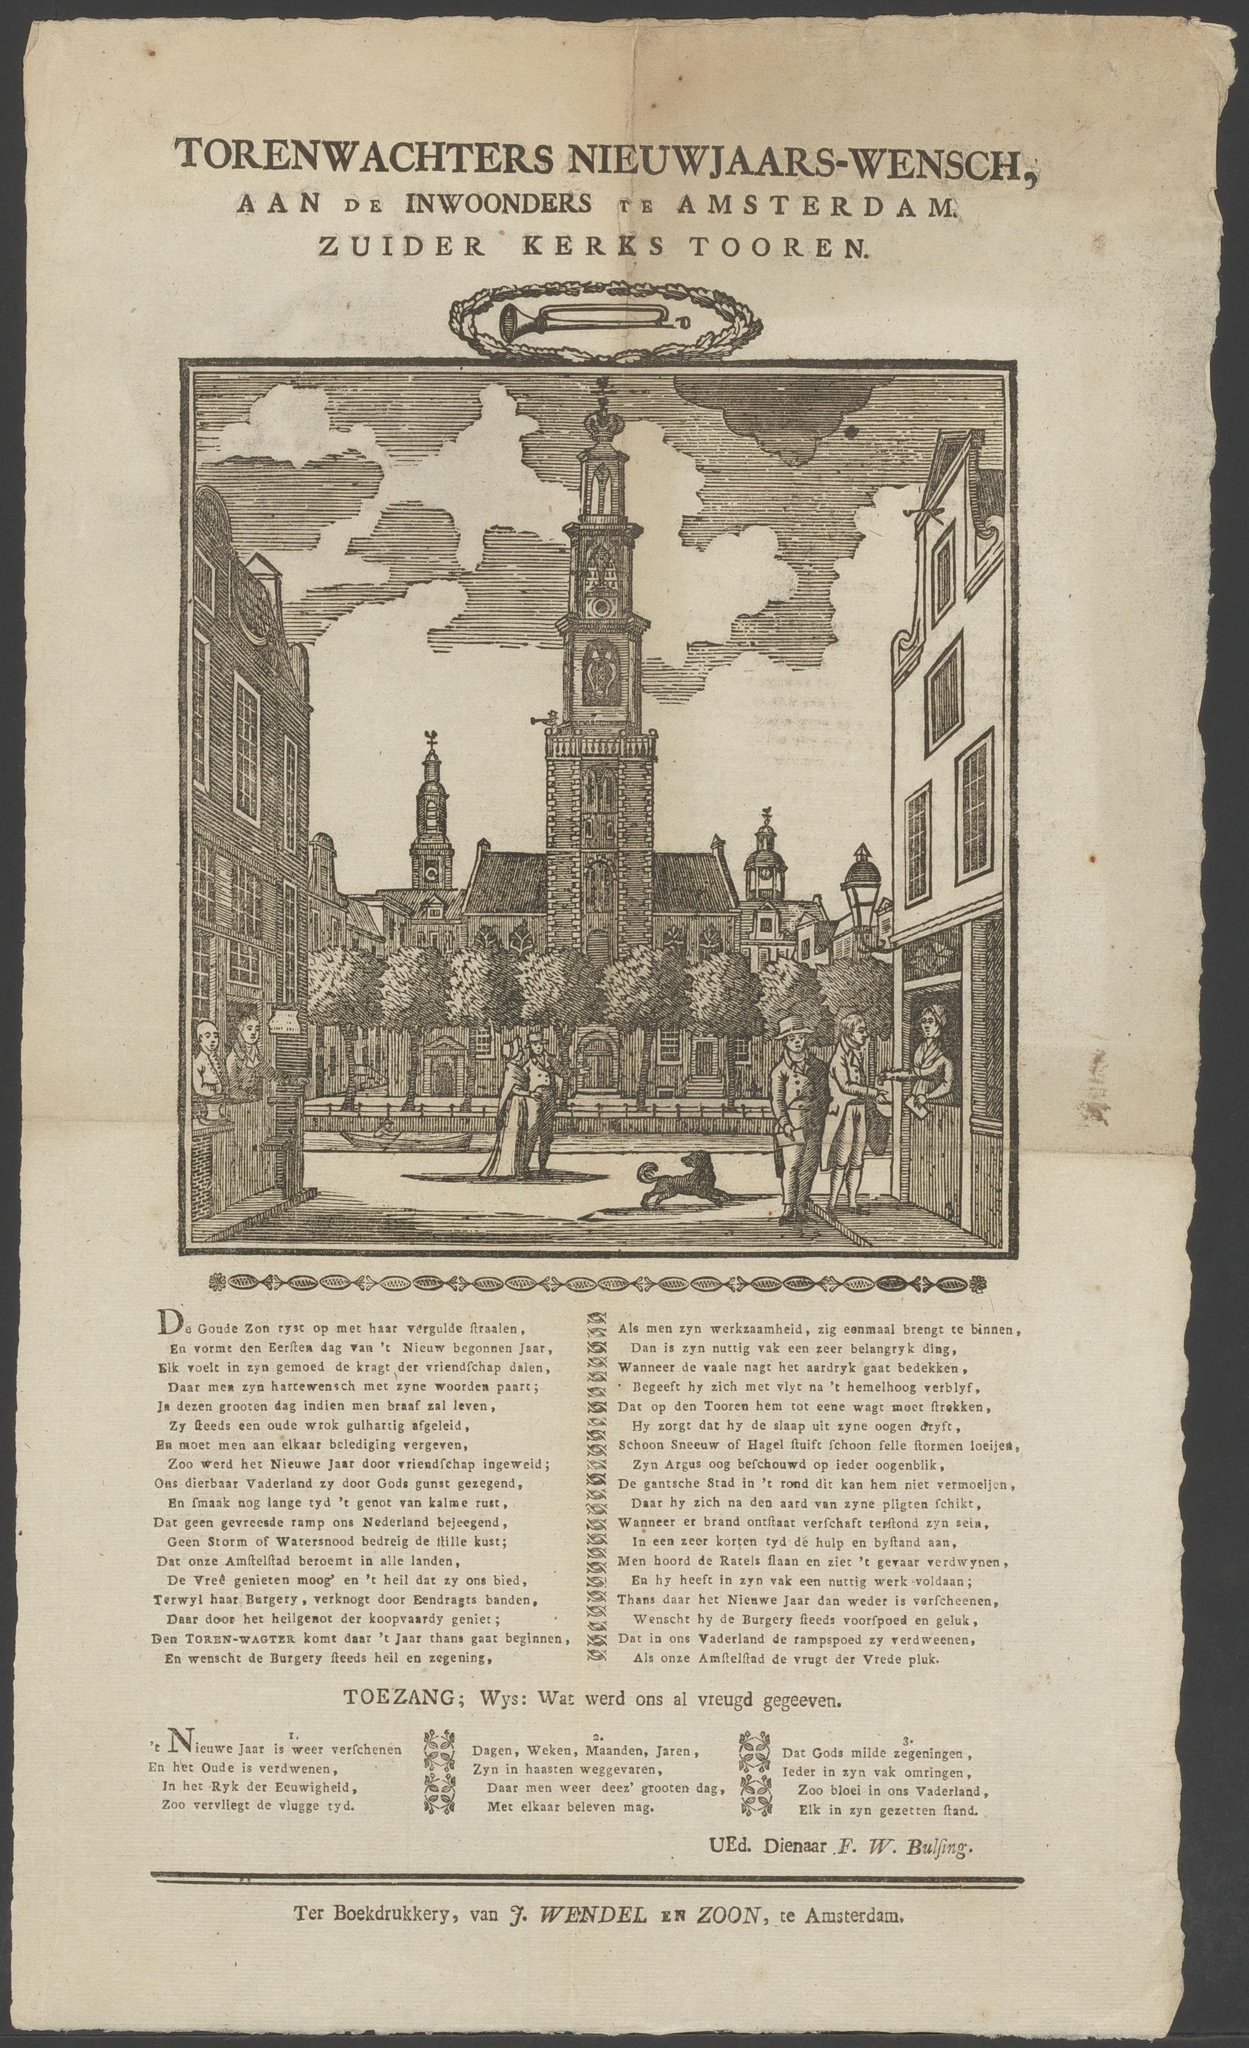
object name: print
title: Torenwachters Nieuwjaars-wensch, aan de inwoners te Amsterdam Zuider Kerks Tooren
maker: Anonymous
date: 1819-1842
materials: paper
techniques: letterpress printing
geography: amsterdam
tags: parts of church exterior and annexes: tower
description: Nieuwjaarswens van de torenwachters van de Zuiderkerkstoren te Amsterdam. Bovenaan een gezicht op een kerktoren. Daaronder centraal een gedicht en onderaan een toezang in drie kolommen. Aangeboden door de torenwachter: F.W. Bulsing. Onderwerpsrubrieken binnen de Atlas Zeden en Gewoonten: Zeden en gewoonten in engeren zin, Volksleven, Volksbladen, Nieuwjaars- en Kerstwenschen, Amsterdam.